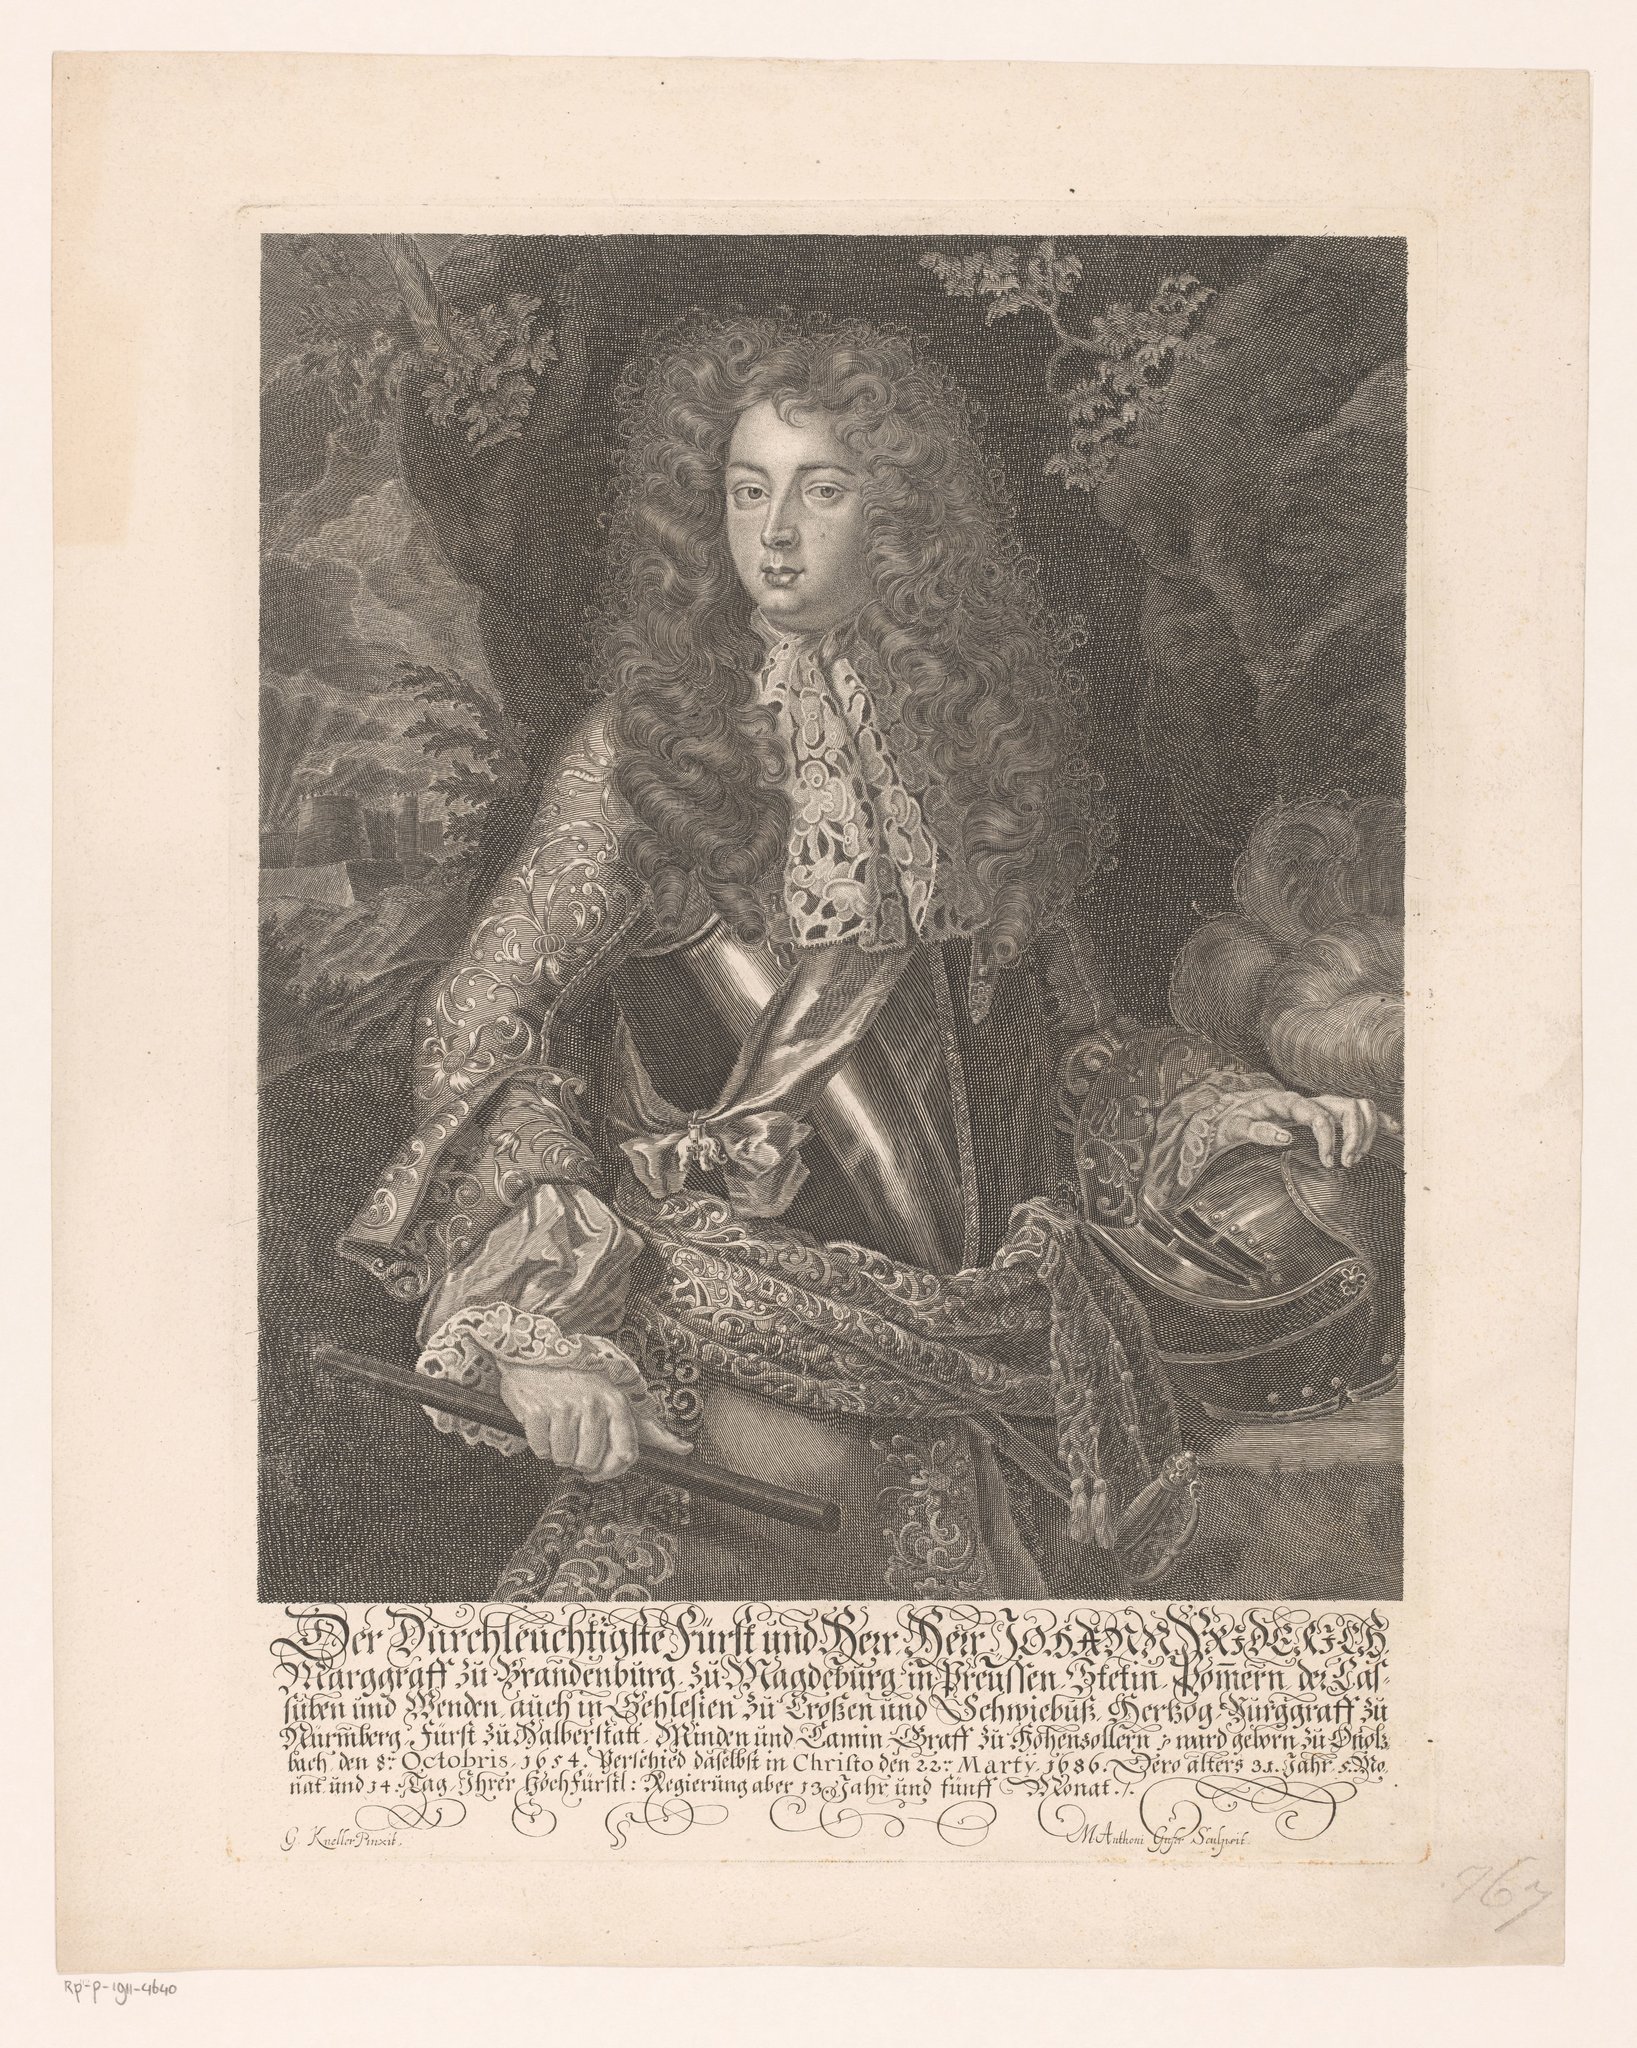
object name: print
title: Portret van Johann Friedrich von Brandenburg-Ansbach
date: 1686-1695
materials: paper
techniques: engraving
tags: city-view, and landscape with man-made constructions, armour, historical persons, ruler, sovereign, baton of general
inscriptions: collector's mark: Lugt 2228